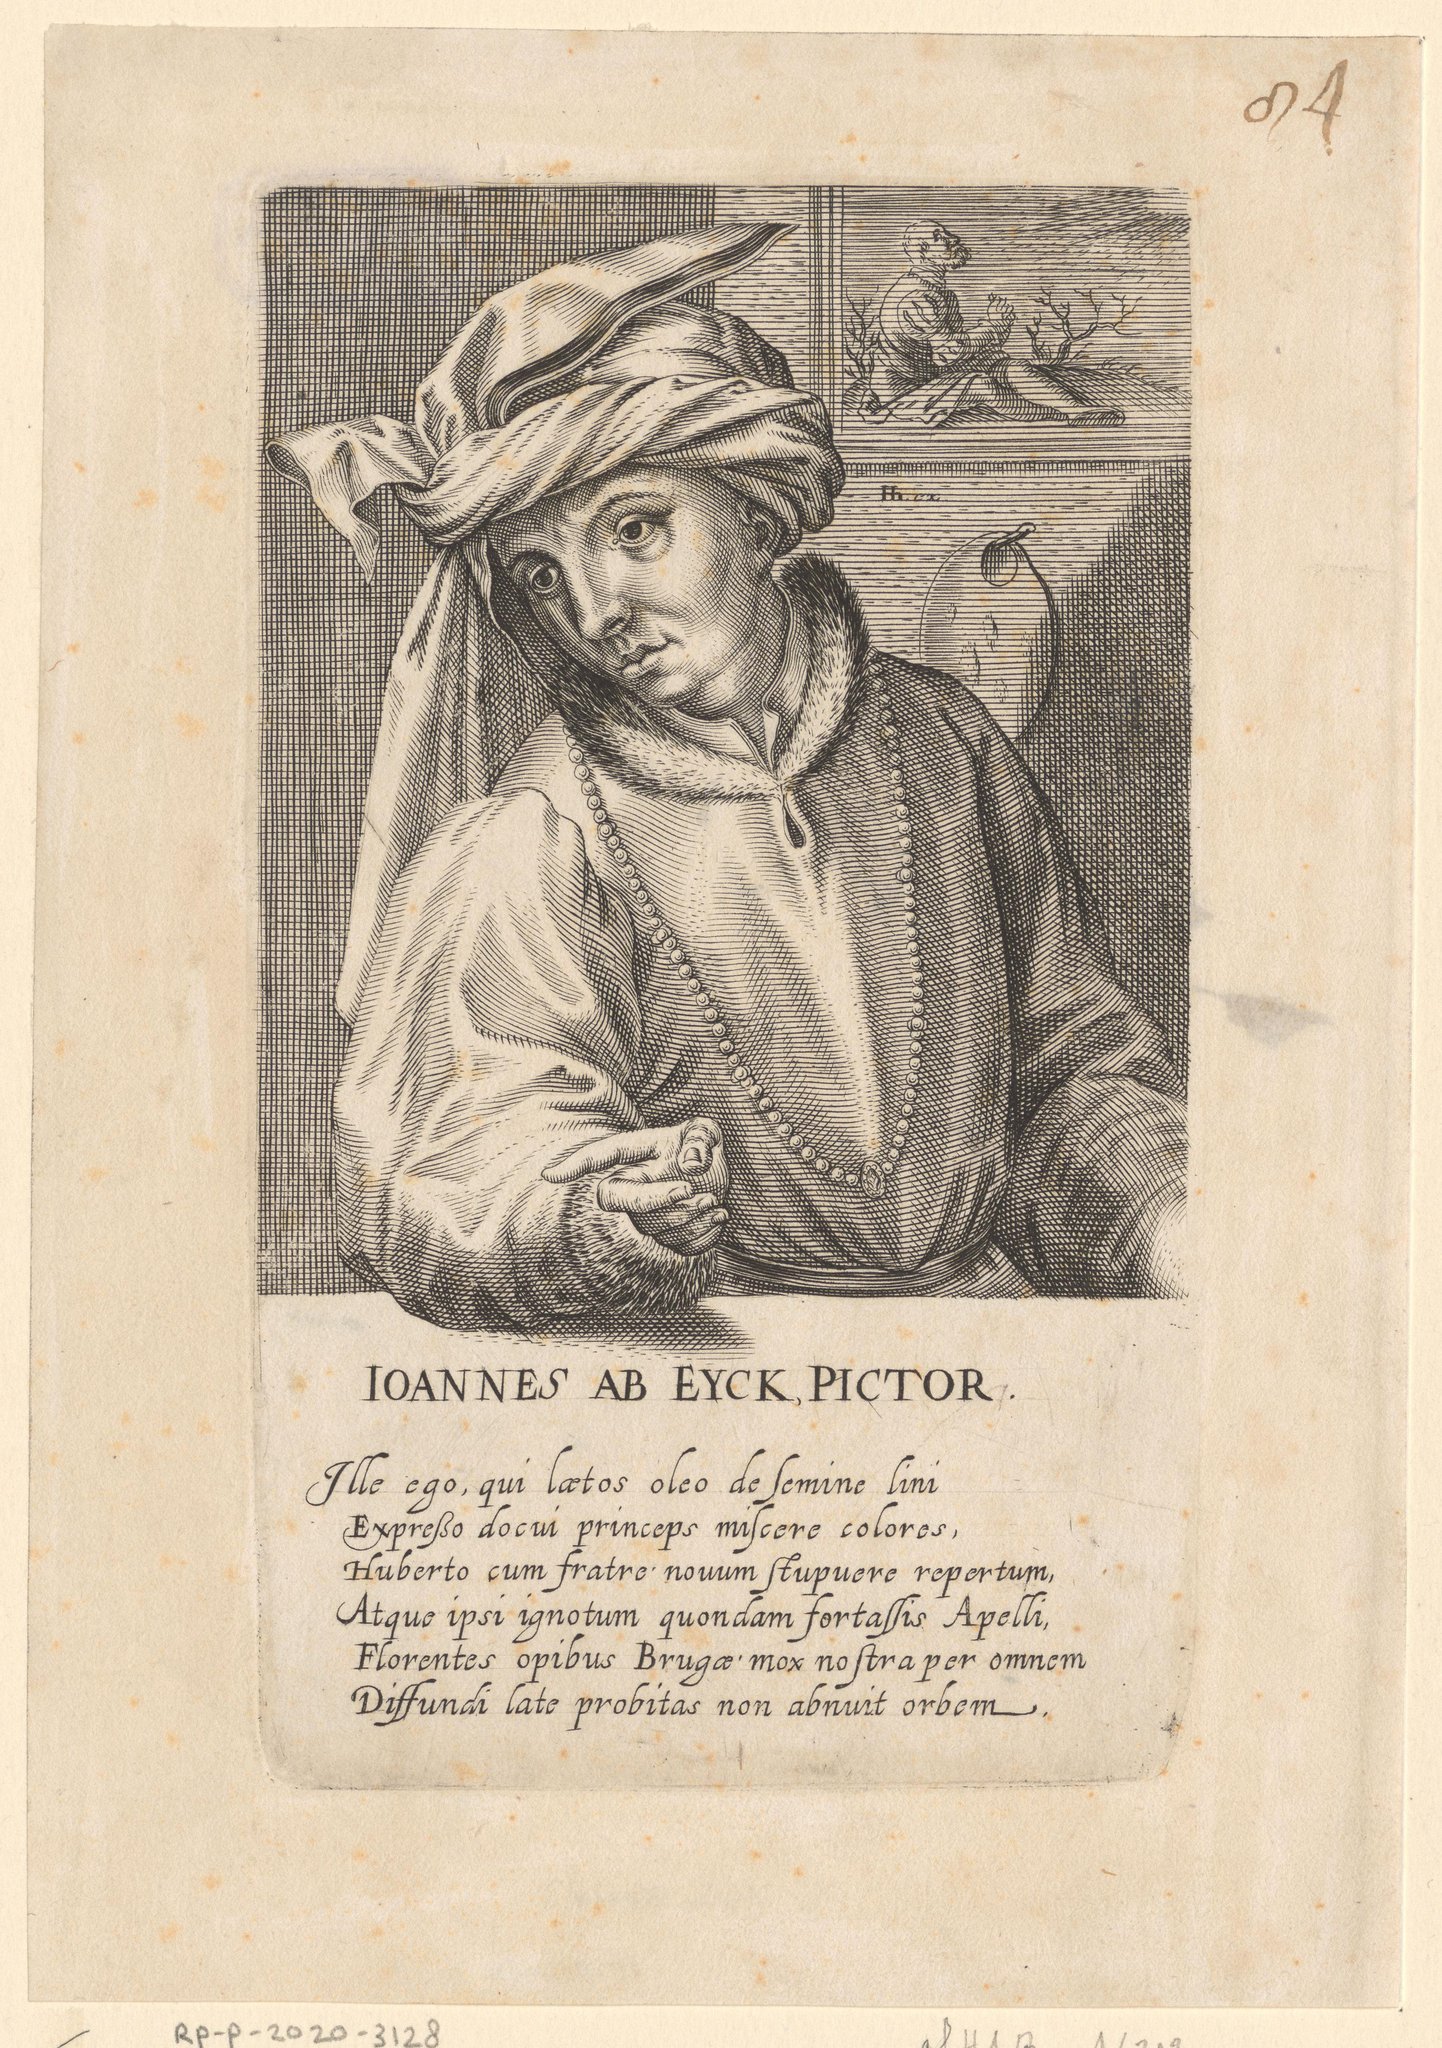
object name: print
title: Portret van Jan van Eyck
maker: hendrick hondius (i)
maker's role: draughtsman, print maker, publisher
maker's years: 1573-1650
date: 1610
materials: paper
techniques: engraving, etching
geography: the hague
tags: bruges, jan van eyck, historical persons, portrait, self-portrait of painter, palette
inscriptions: inscription: ‘84’, collector's mark: Lugt 11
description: Prent uit deel 1 van de serie Pictorum Aliquot Celebrium Praecipuae Germaniae Inferioris Effigies (1610). Serie van 72 kunstenaarsportretten vervaardigd door Hendrick Hondius I, Simon Frisius, Andries Jacobsz. Stock en Robert de Baudous. Prent ook gebruikt in tweede druk uit 1618. Prent is een kopie van de prent door (mogelijk) Johannes Wierix uit de portrettenserie uitgegeven door Volcxken Diericx, zie Van Someren.